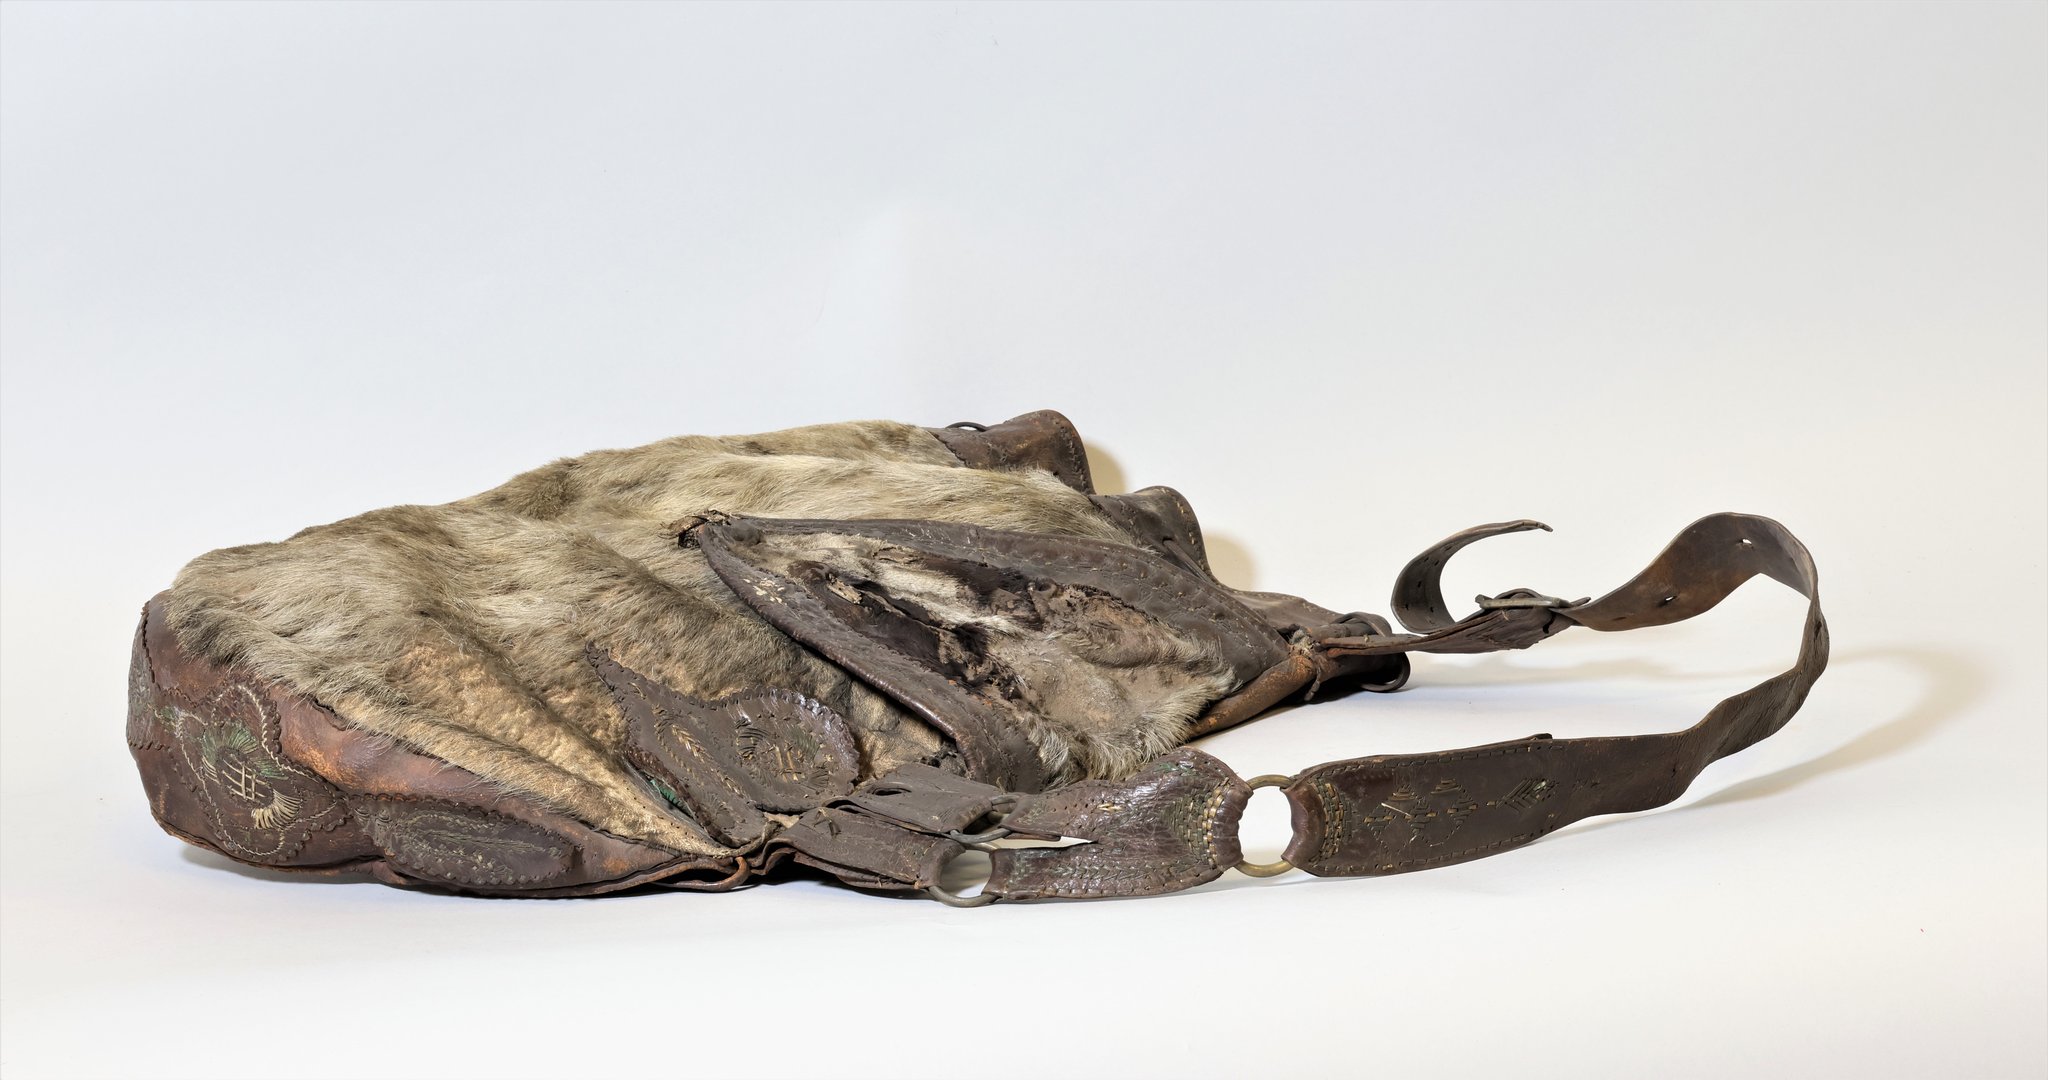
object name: bagpipe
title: Bagpipe Bag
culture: german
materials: leather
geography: germany